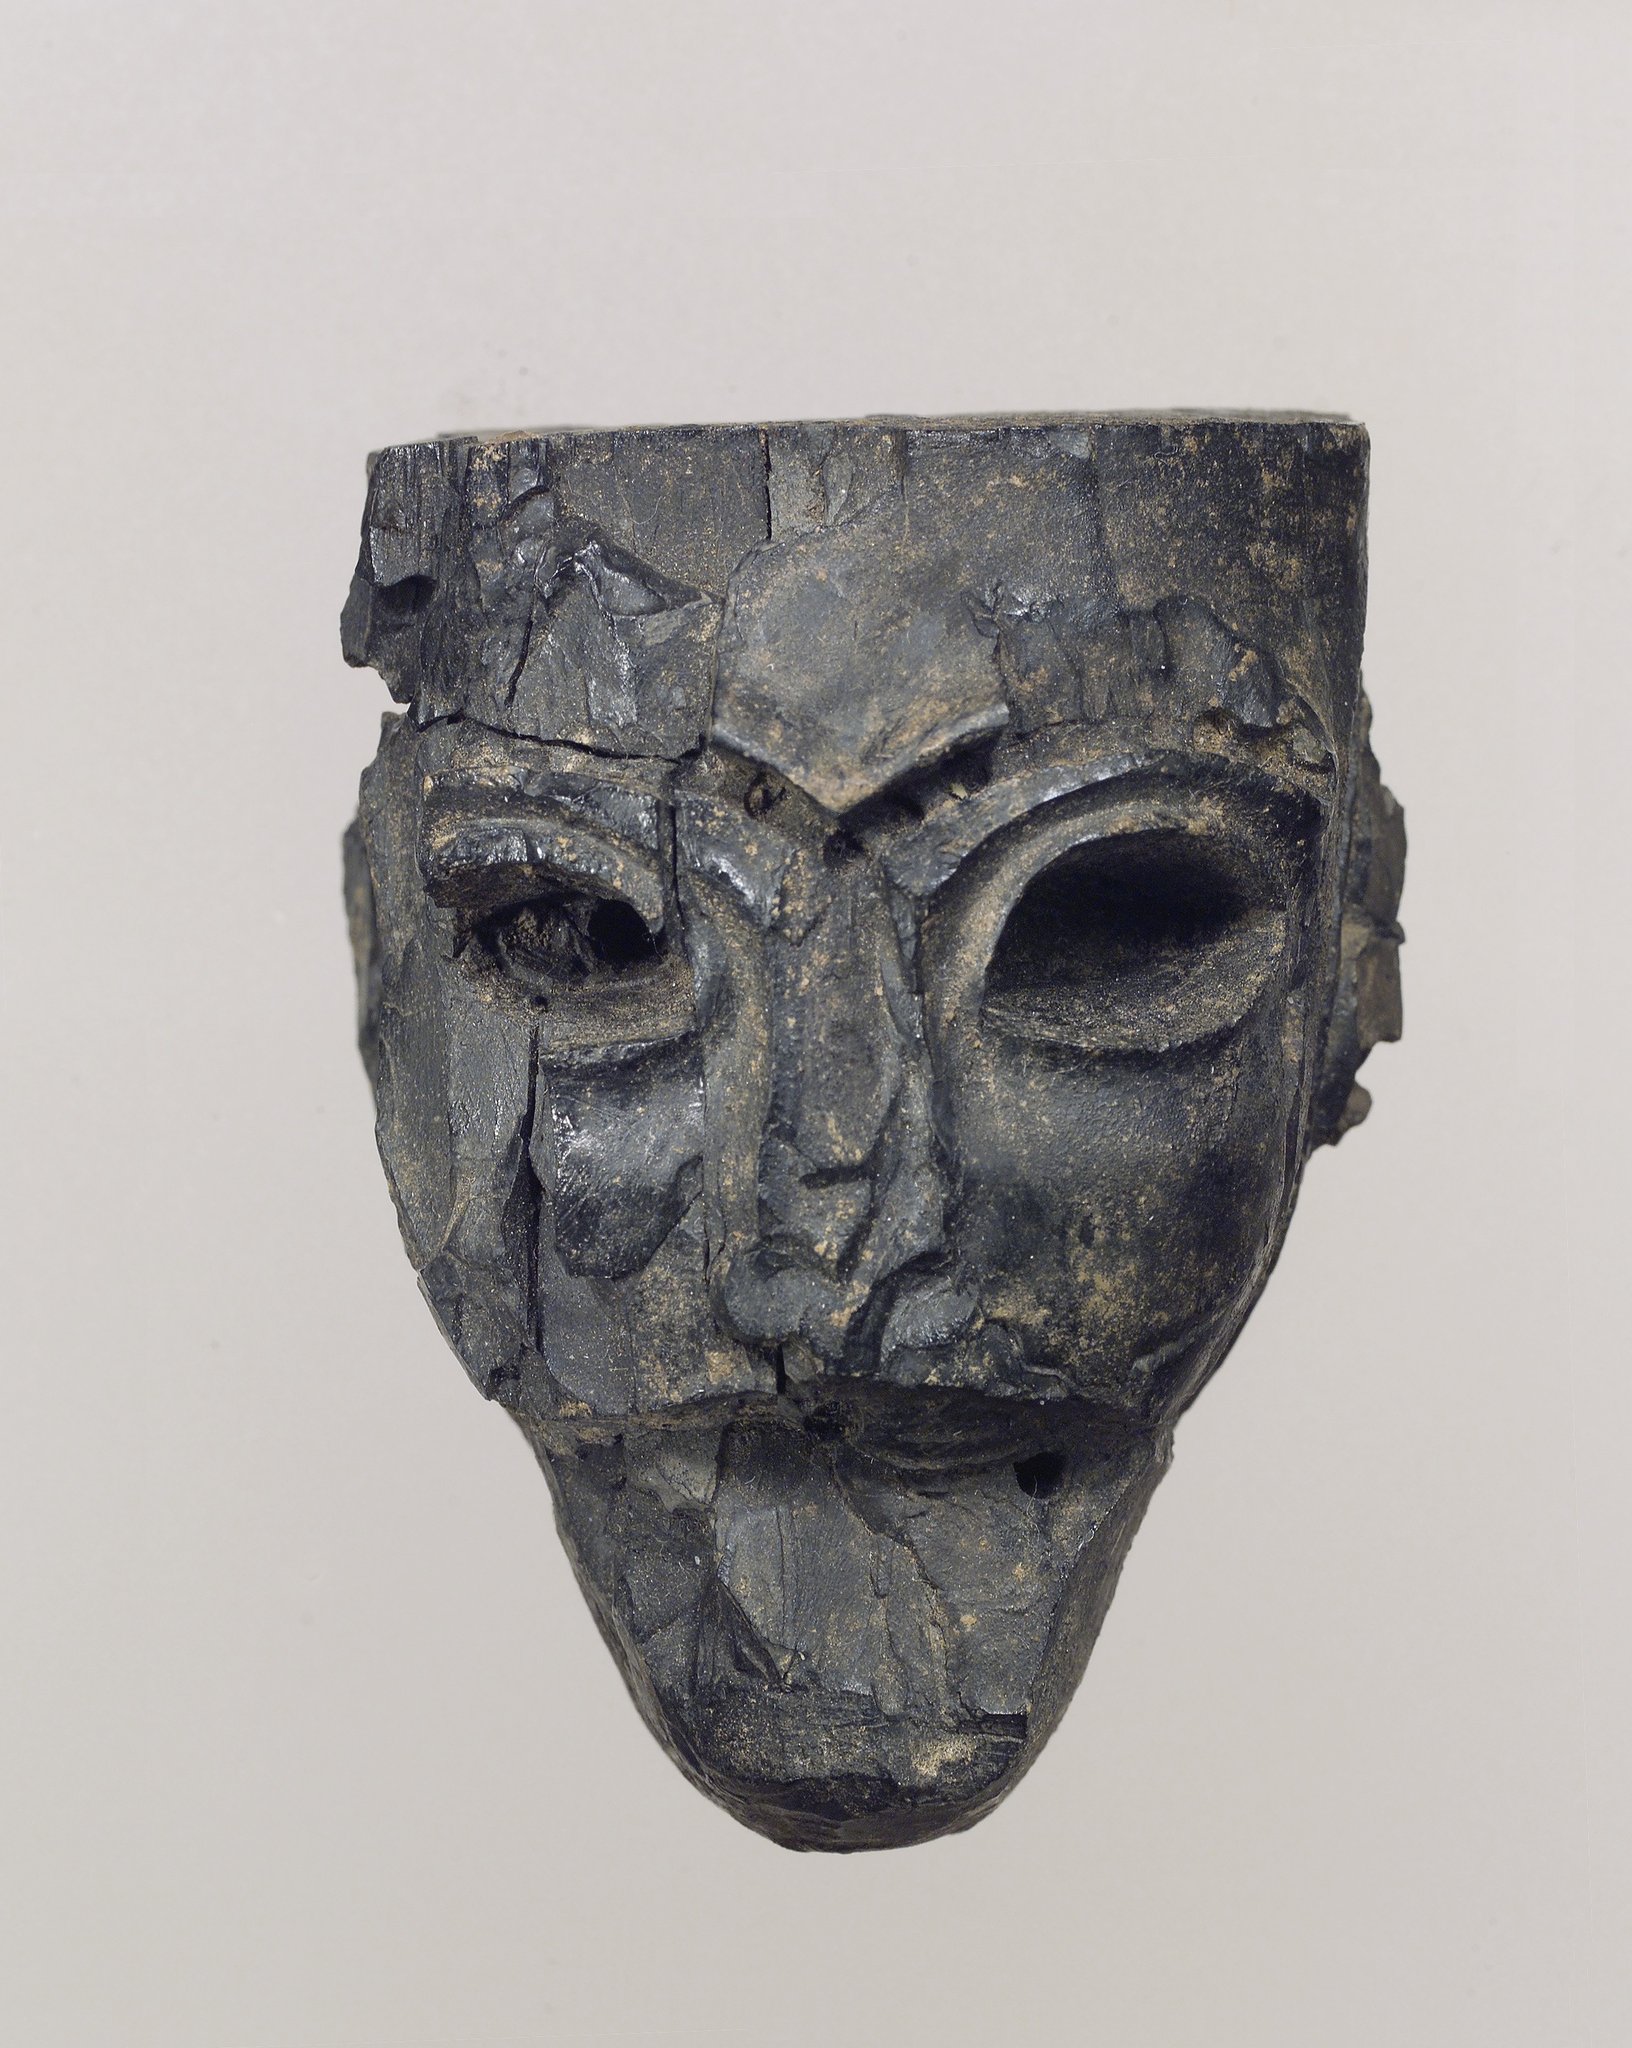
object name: sculpture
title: Male head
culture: iranian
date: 900-801 BCE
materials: ivory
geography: iran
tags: heads,men